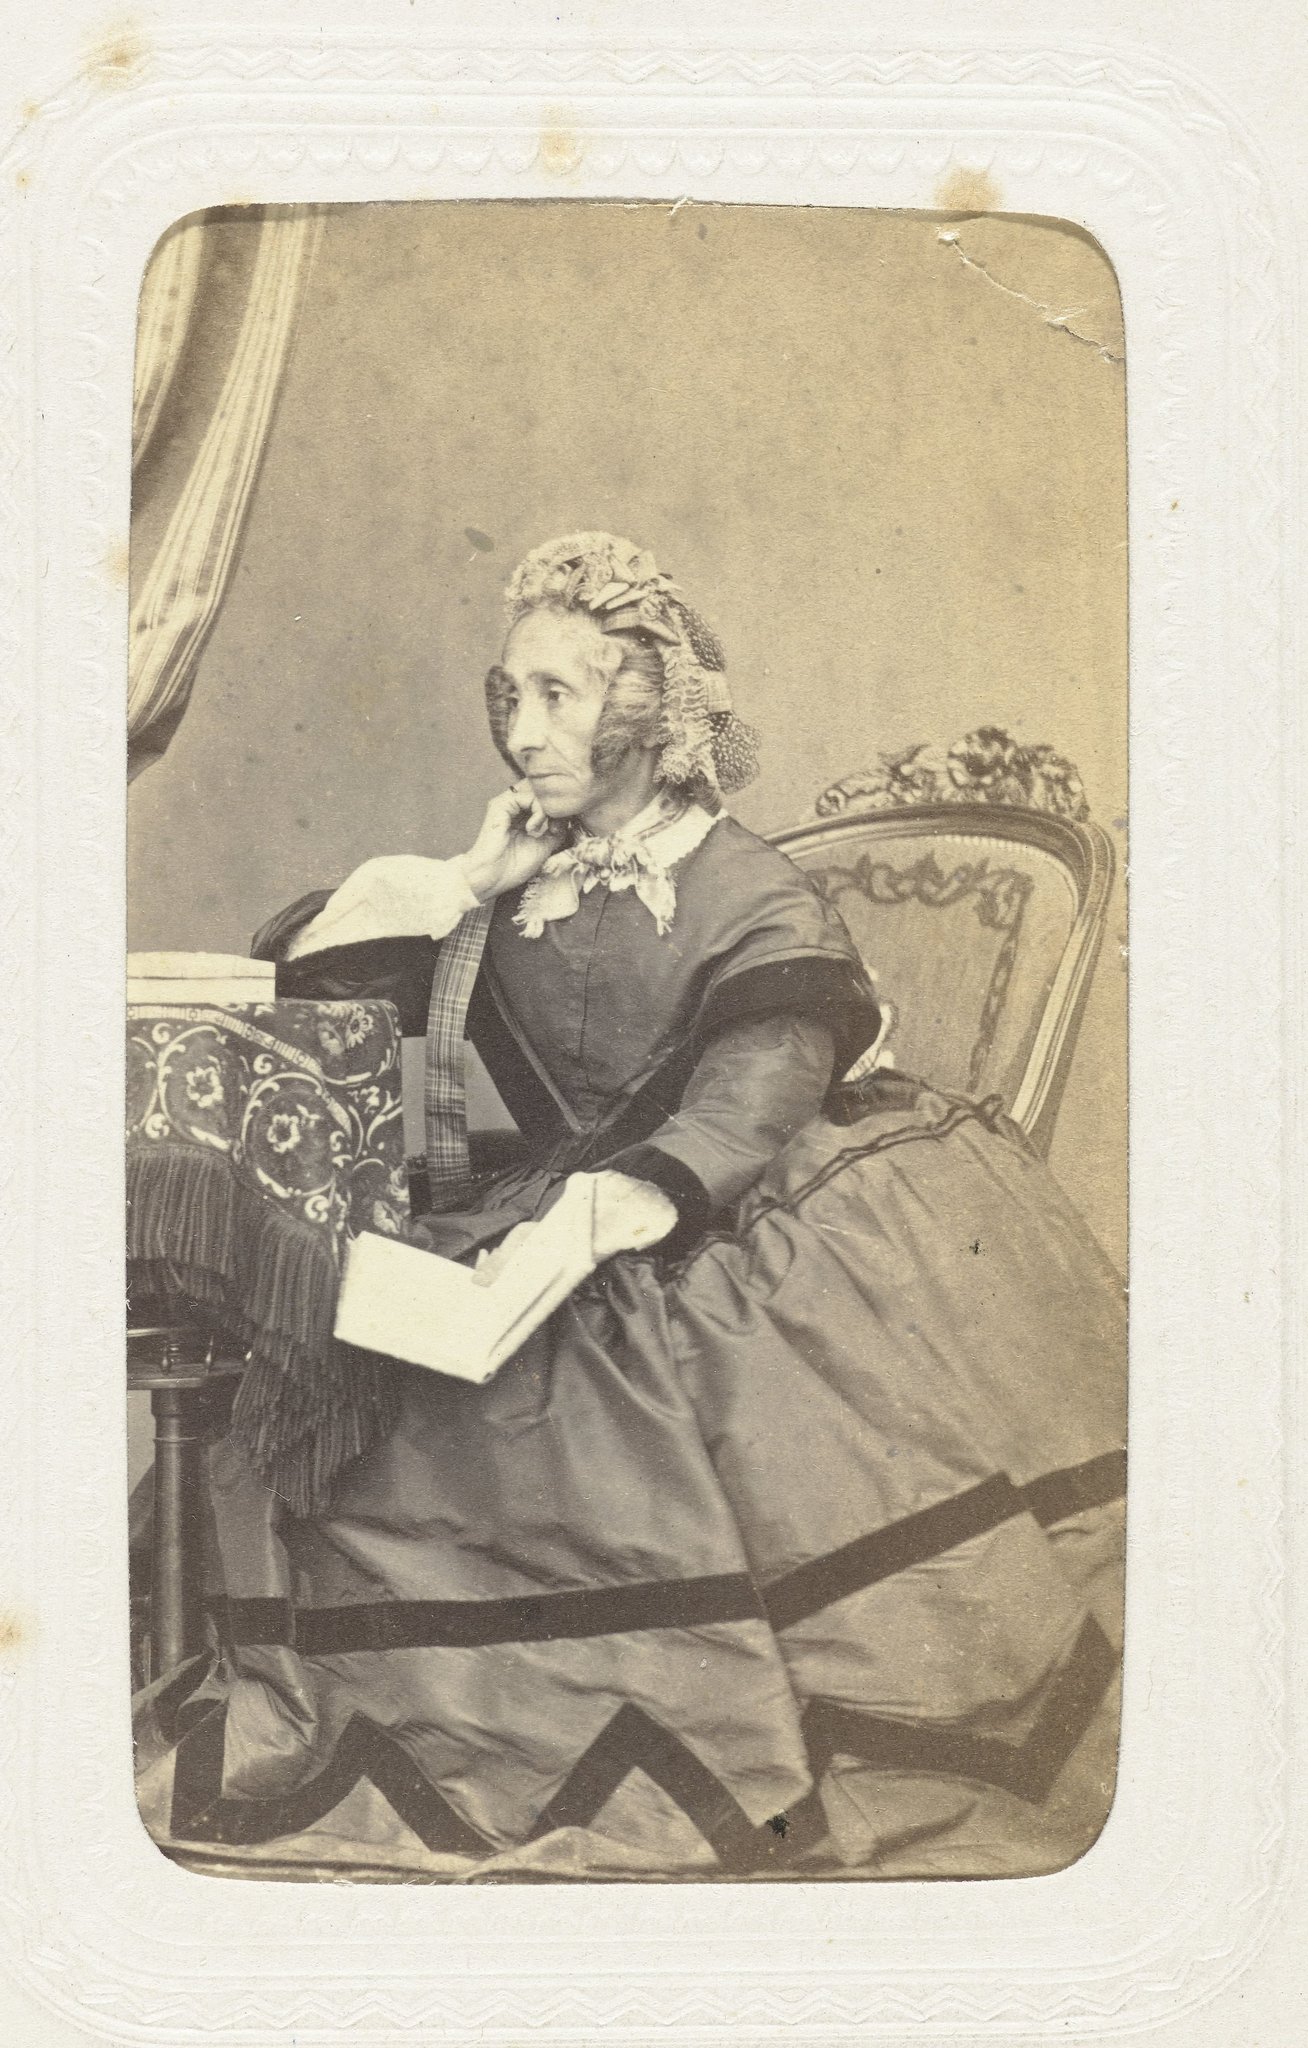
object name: carte de visite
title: Studioportret van een oudere vrouw in een stoel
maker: Anonymous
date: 1863-1866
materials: cardboard, paper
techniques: albumen print